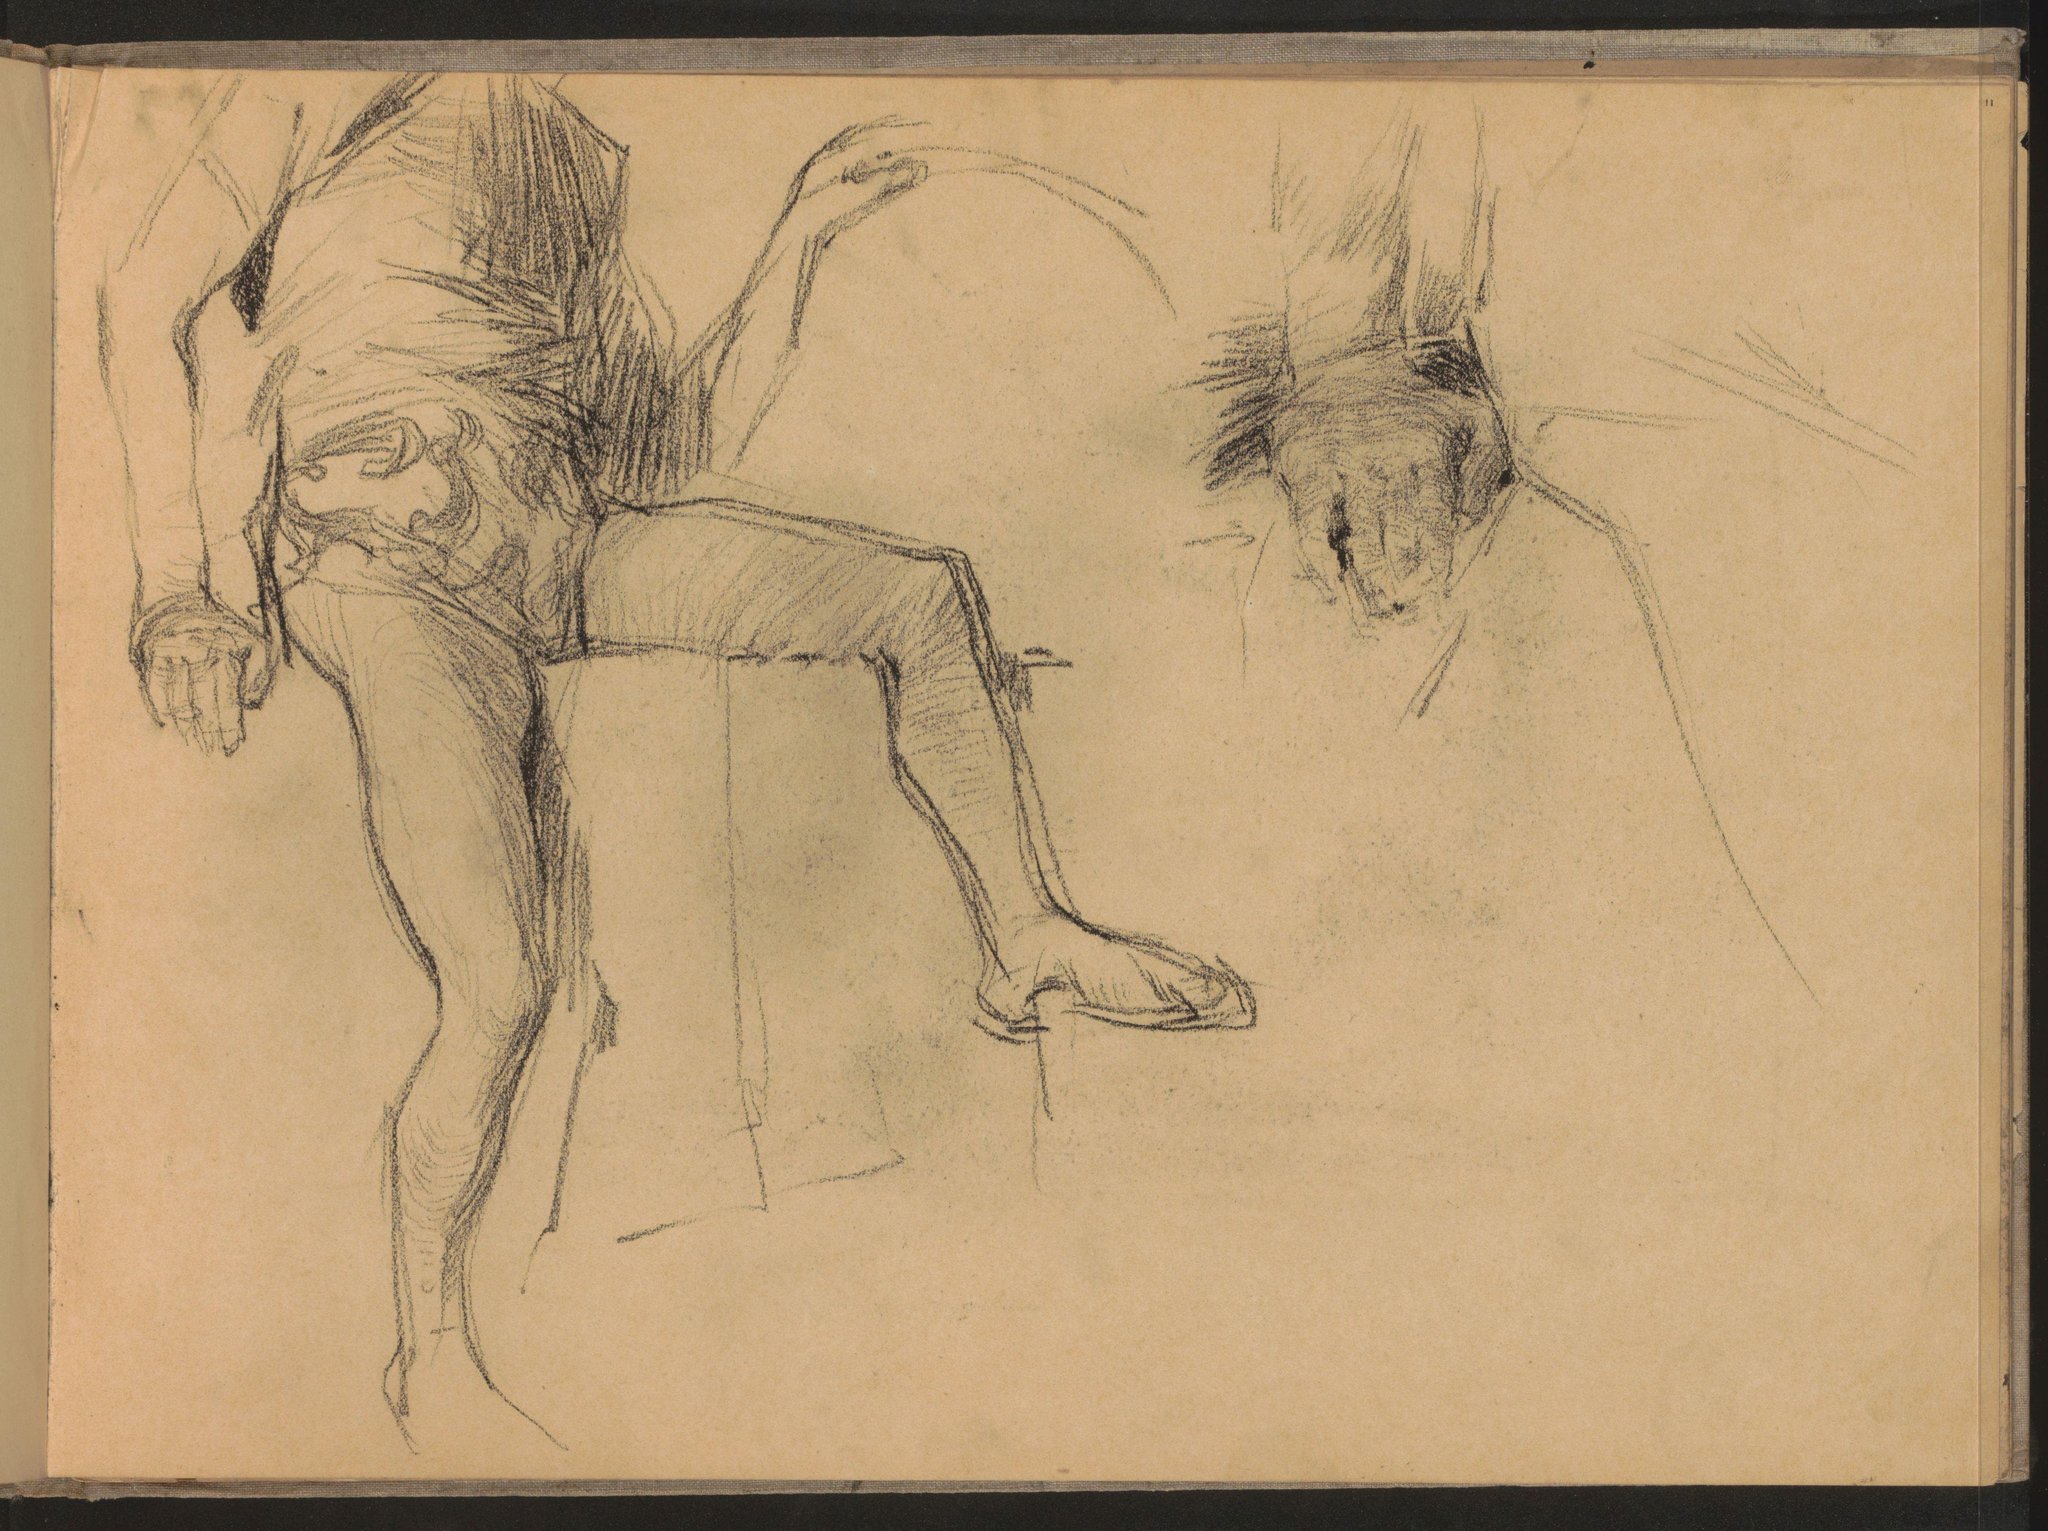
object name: sketchbook leaf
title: Zittend naakt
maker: marius bauer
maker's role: draughtsman, print maker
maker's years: 1867-1932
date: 1887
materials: chalk, paper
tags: sitting figure, the (nude) human figure; 'corpo humano' (ripa) - aa - female human figure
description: Tevens een studie van een hand. Pagina 11 uit een schetsboek met 19 bladen.